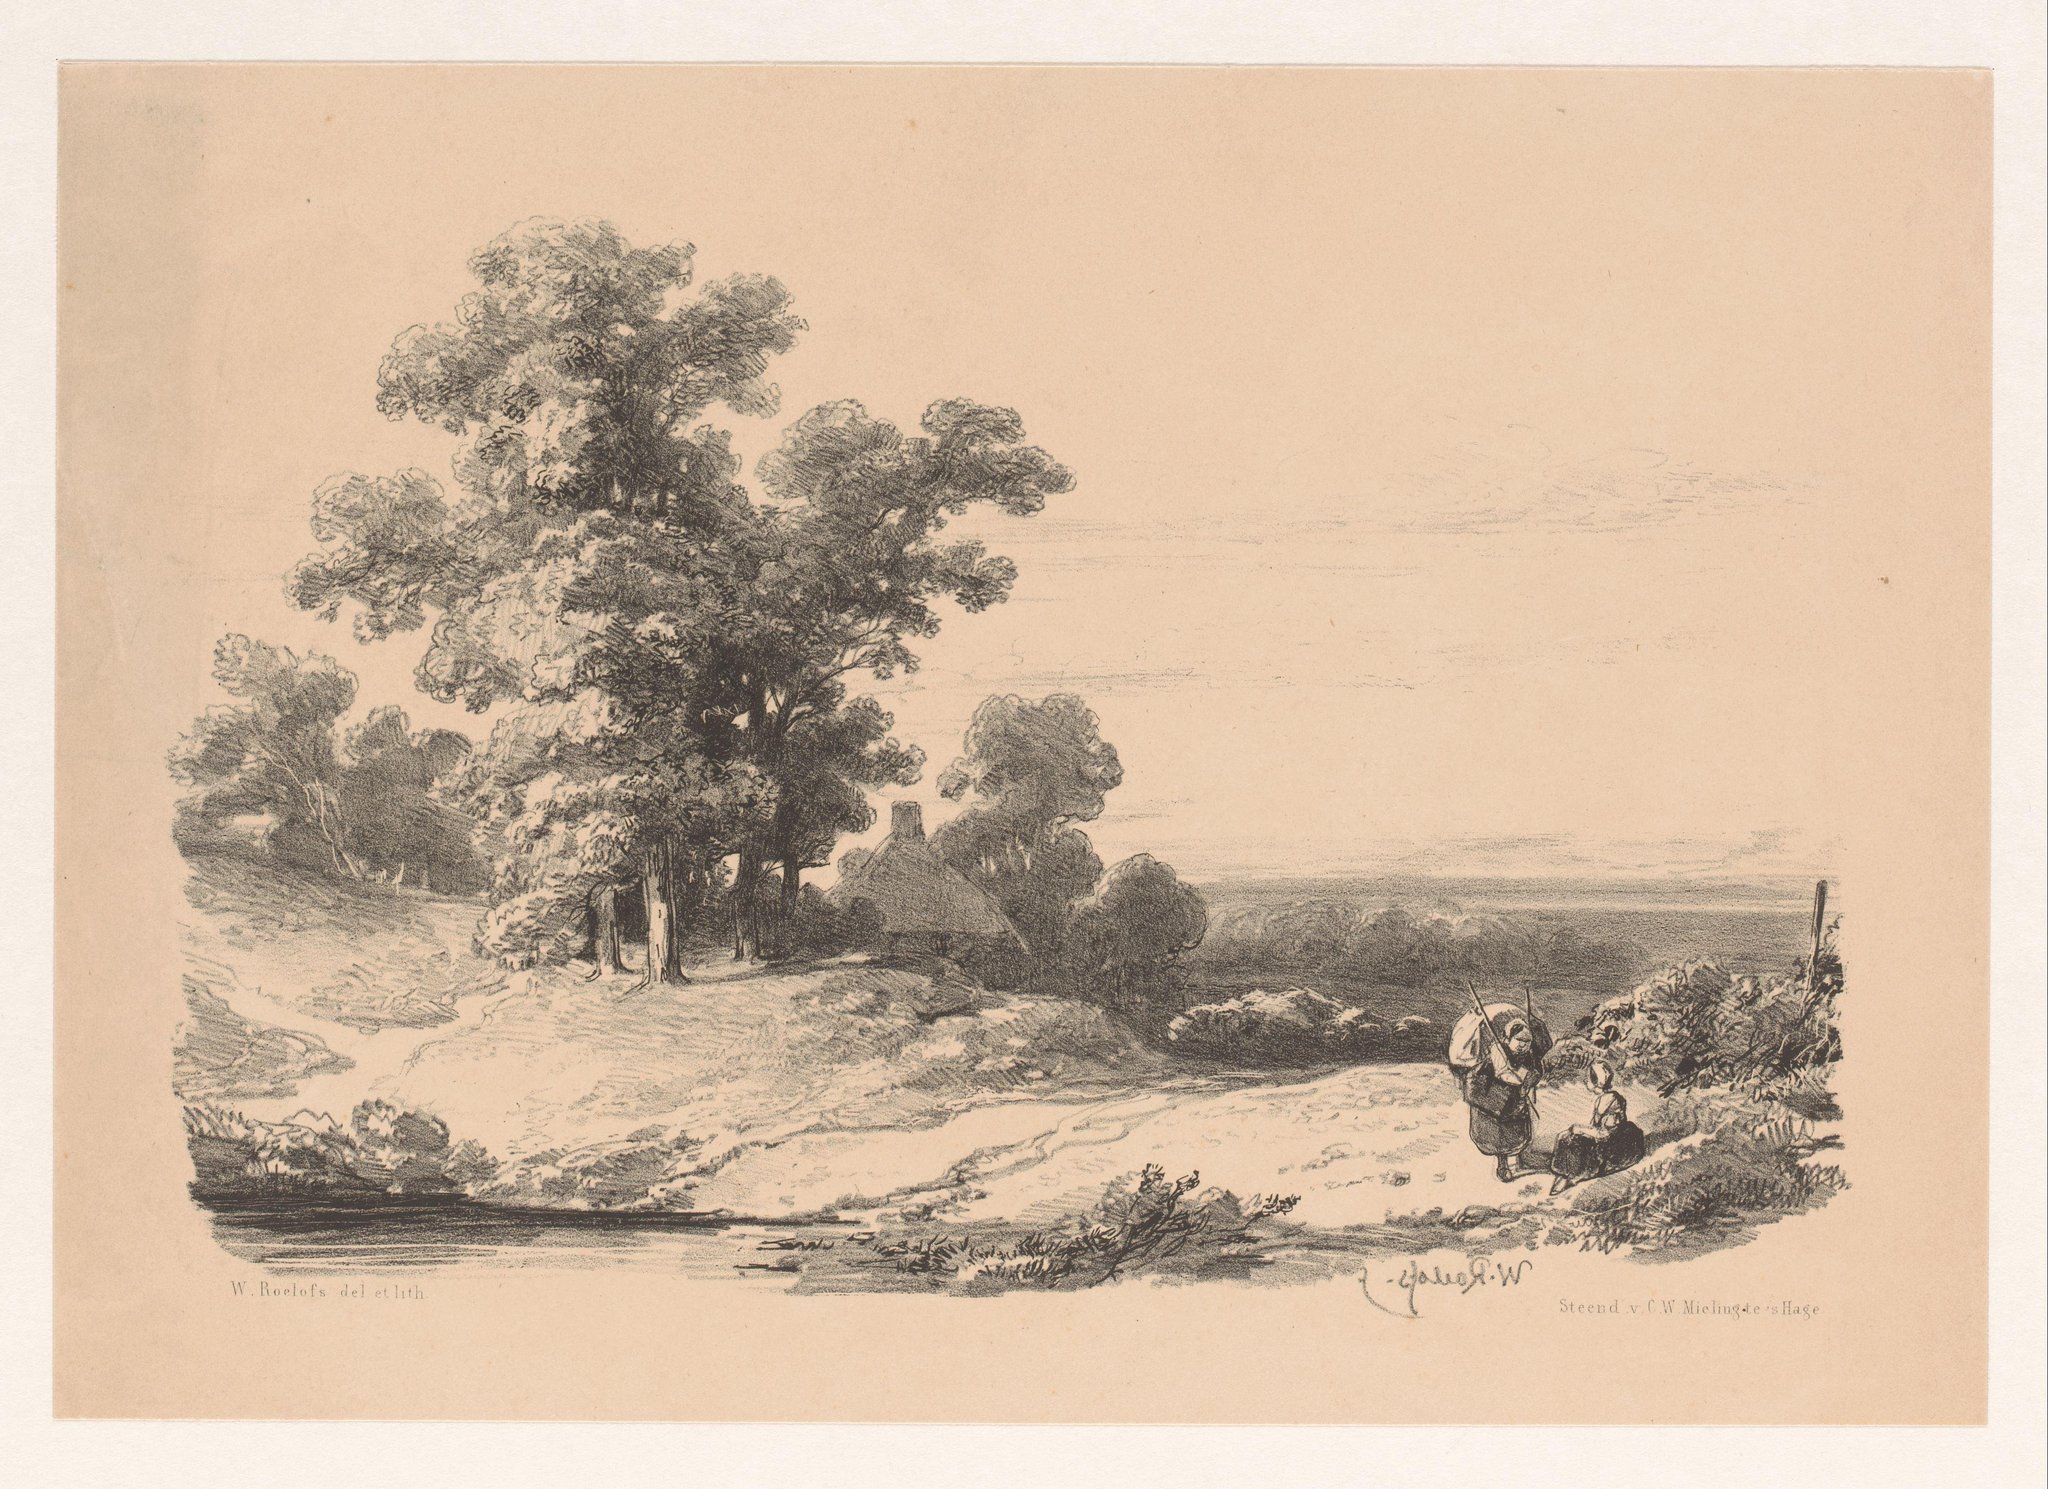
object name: print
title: Landschap met twee vrouwen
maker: willem roelofs (i)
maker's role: draughtsman, painter, print maker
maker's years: 1822-1897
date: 1847-1865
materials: paper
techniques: lithograph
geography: the hague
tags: landscapes (+ landscape with figures, staffage)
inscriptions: collector's mark: Lugt 2228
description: Een vrouw met rugzak staat tegenover een zittende vrouw in een landschap met water, boompartijen en in de achtergrond een huis.